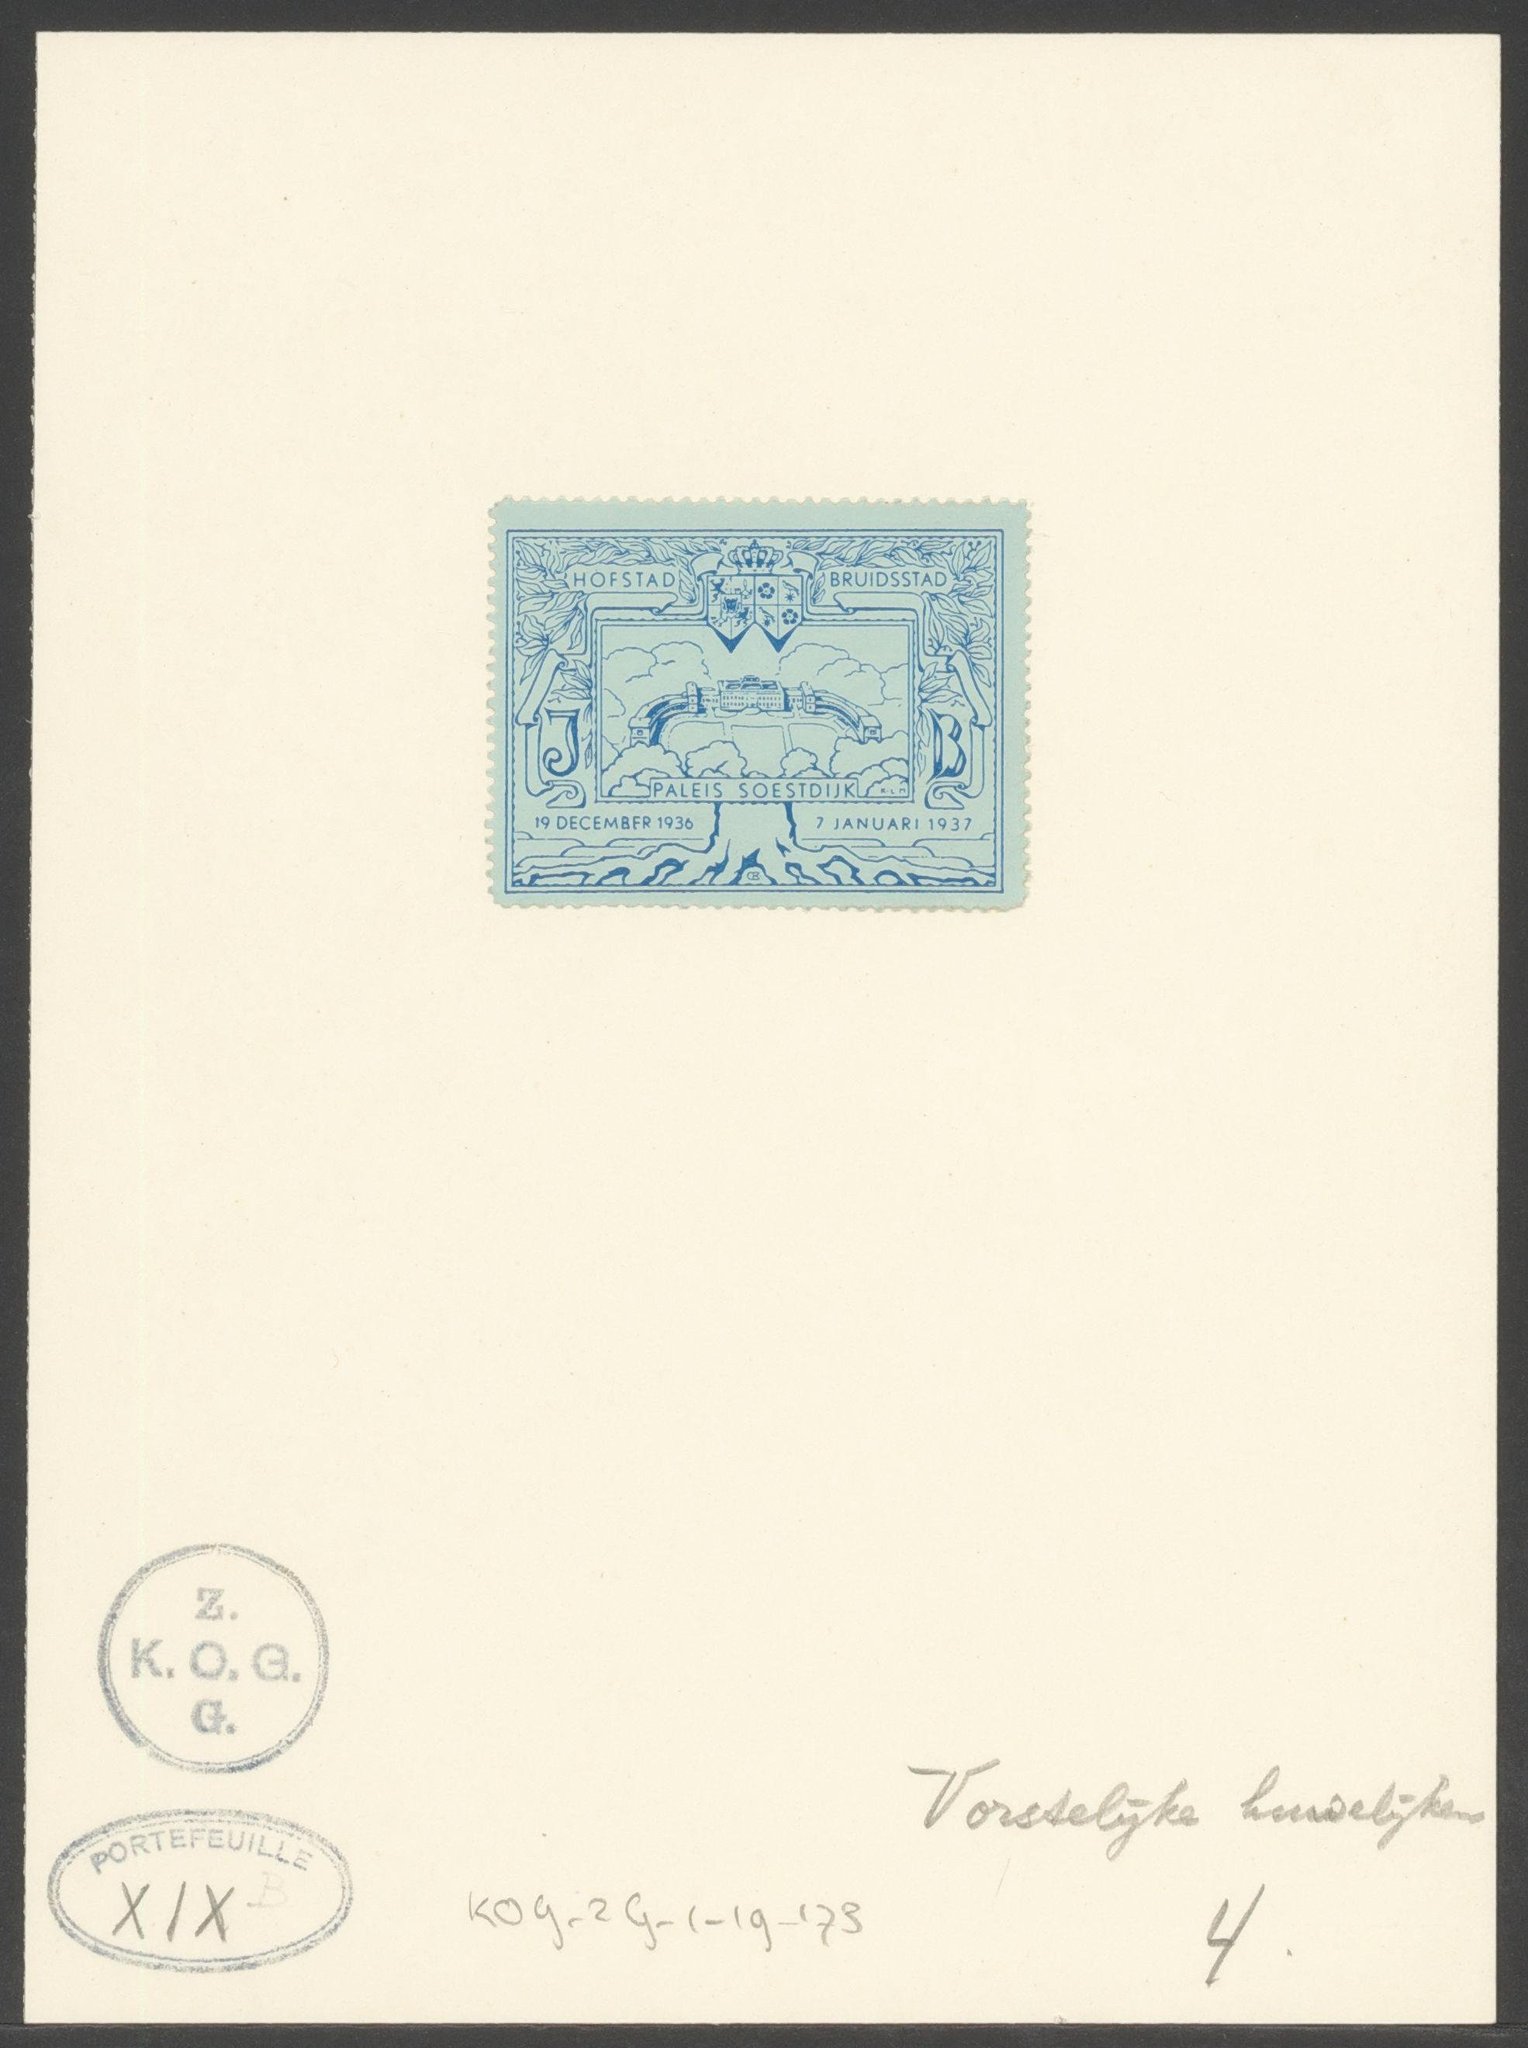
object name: sluitzegel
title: Sluitzegel 'Hofstad Bruidsstad'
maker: Anonymous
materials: paper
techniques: lithograph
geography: netherlands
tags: utrecht, bernhard (prins der nederlanden), the hague, juliana of the netherlands, palace, marriage, married couple, 'matrimonium'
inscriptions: collector's mark: Lugt 1641, collector's mark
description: Sluitzegel 'Hofstad Bruidsstad' met gezicht op Paleis Soestdijk, ter gelegenheid van het huwelijk van prinses Juliana en prins Bernhard op 7 januari 1937. Onderwerpsrubrieken binnen de Atlas Zeden en Gewoonten: Des Menschen Begin, Midden en Einde. Vorstelijke huwelijken.